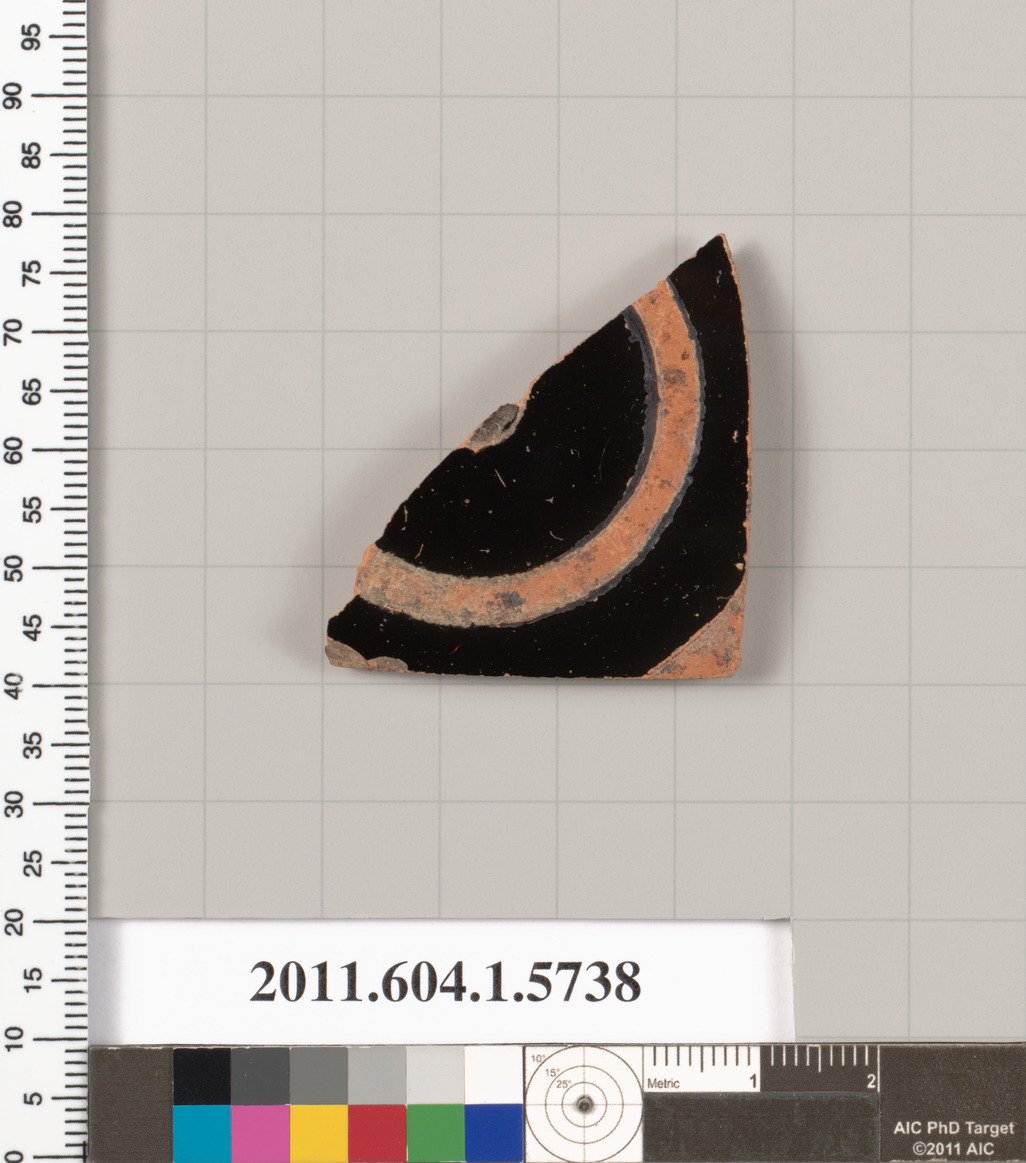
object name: kylix fragment, eye cup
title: Terracotta fragment of a kylix: eye-cup (drinking cup)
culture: greek, attic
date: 525-515 BCE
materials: terracotta